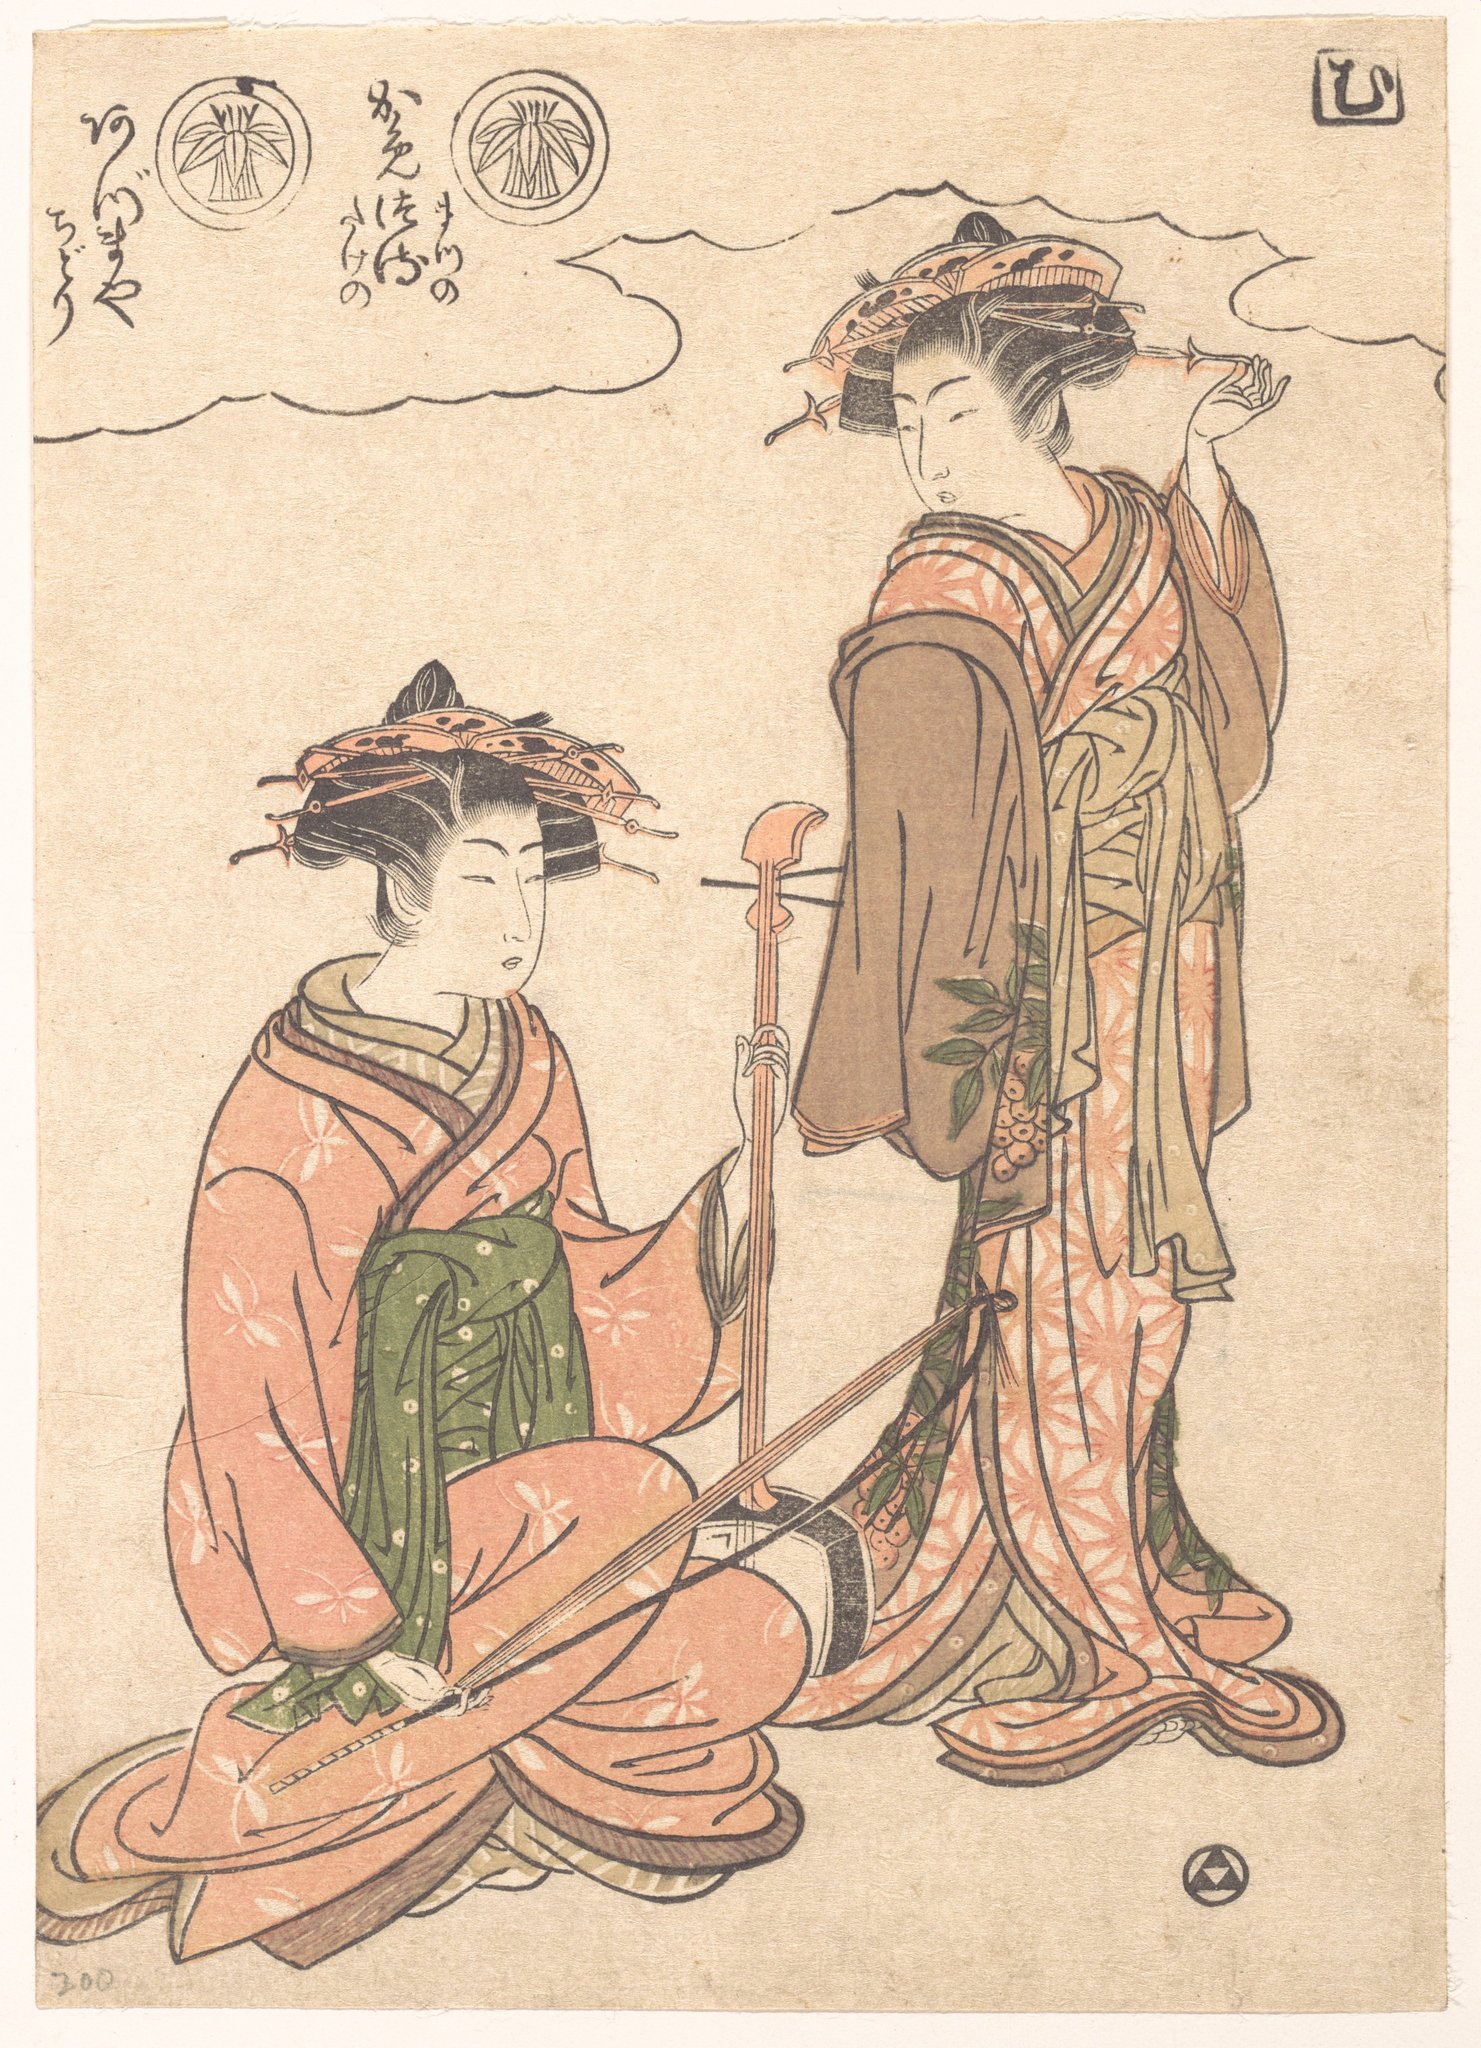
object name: print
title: Two Geisha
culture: japanese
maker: isoda koryūsai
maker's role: artist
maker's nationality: japanese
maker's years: 1735-1790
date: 1770-1790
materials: ink, paper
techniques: woodblock print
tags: musical instruments,women